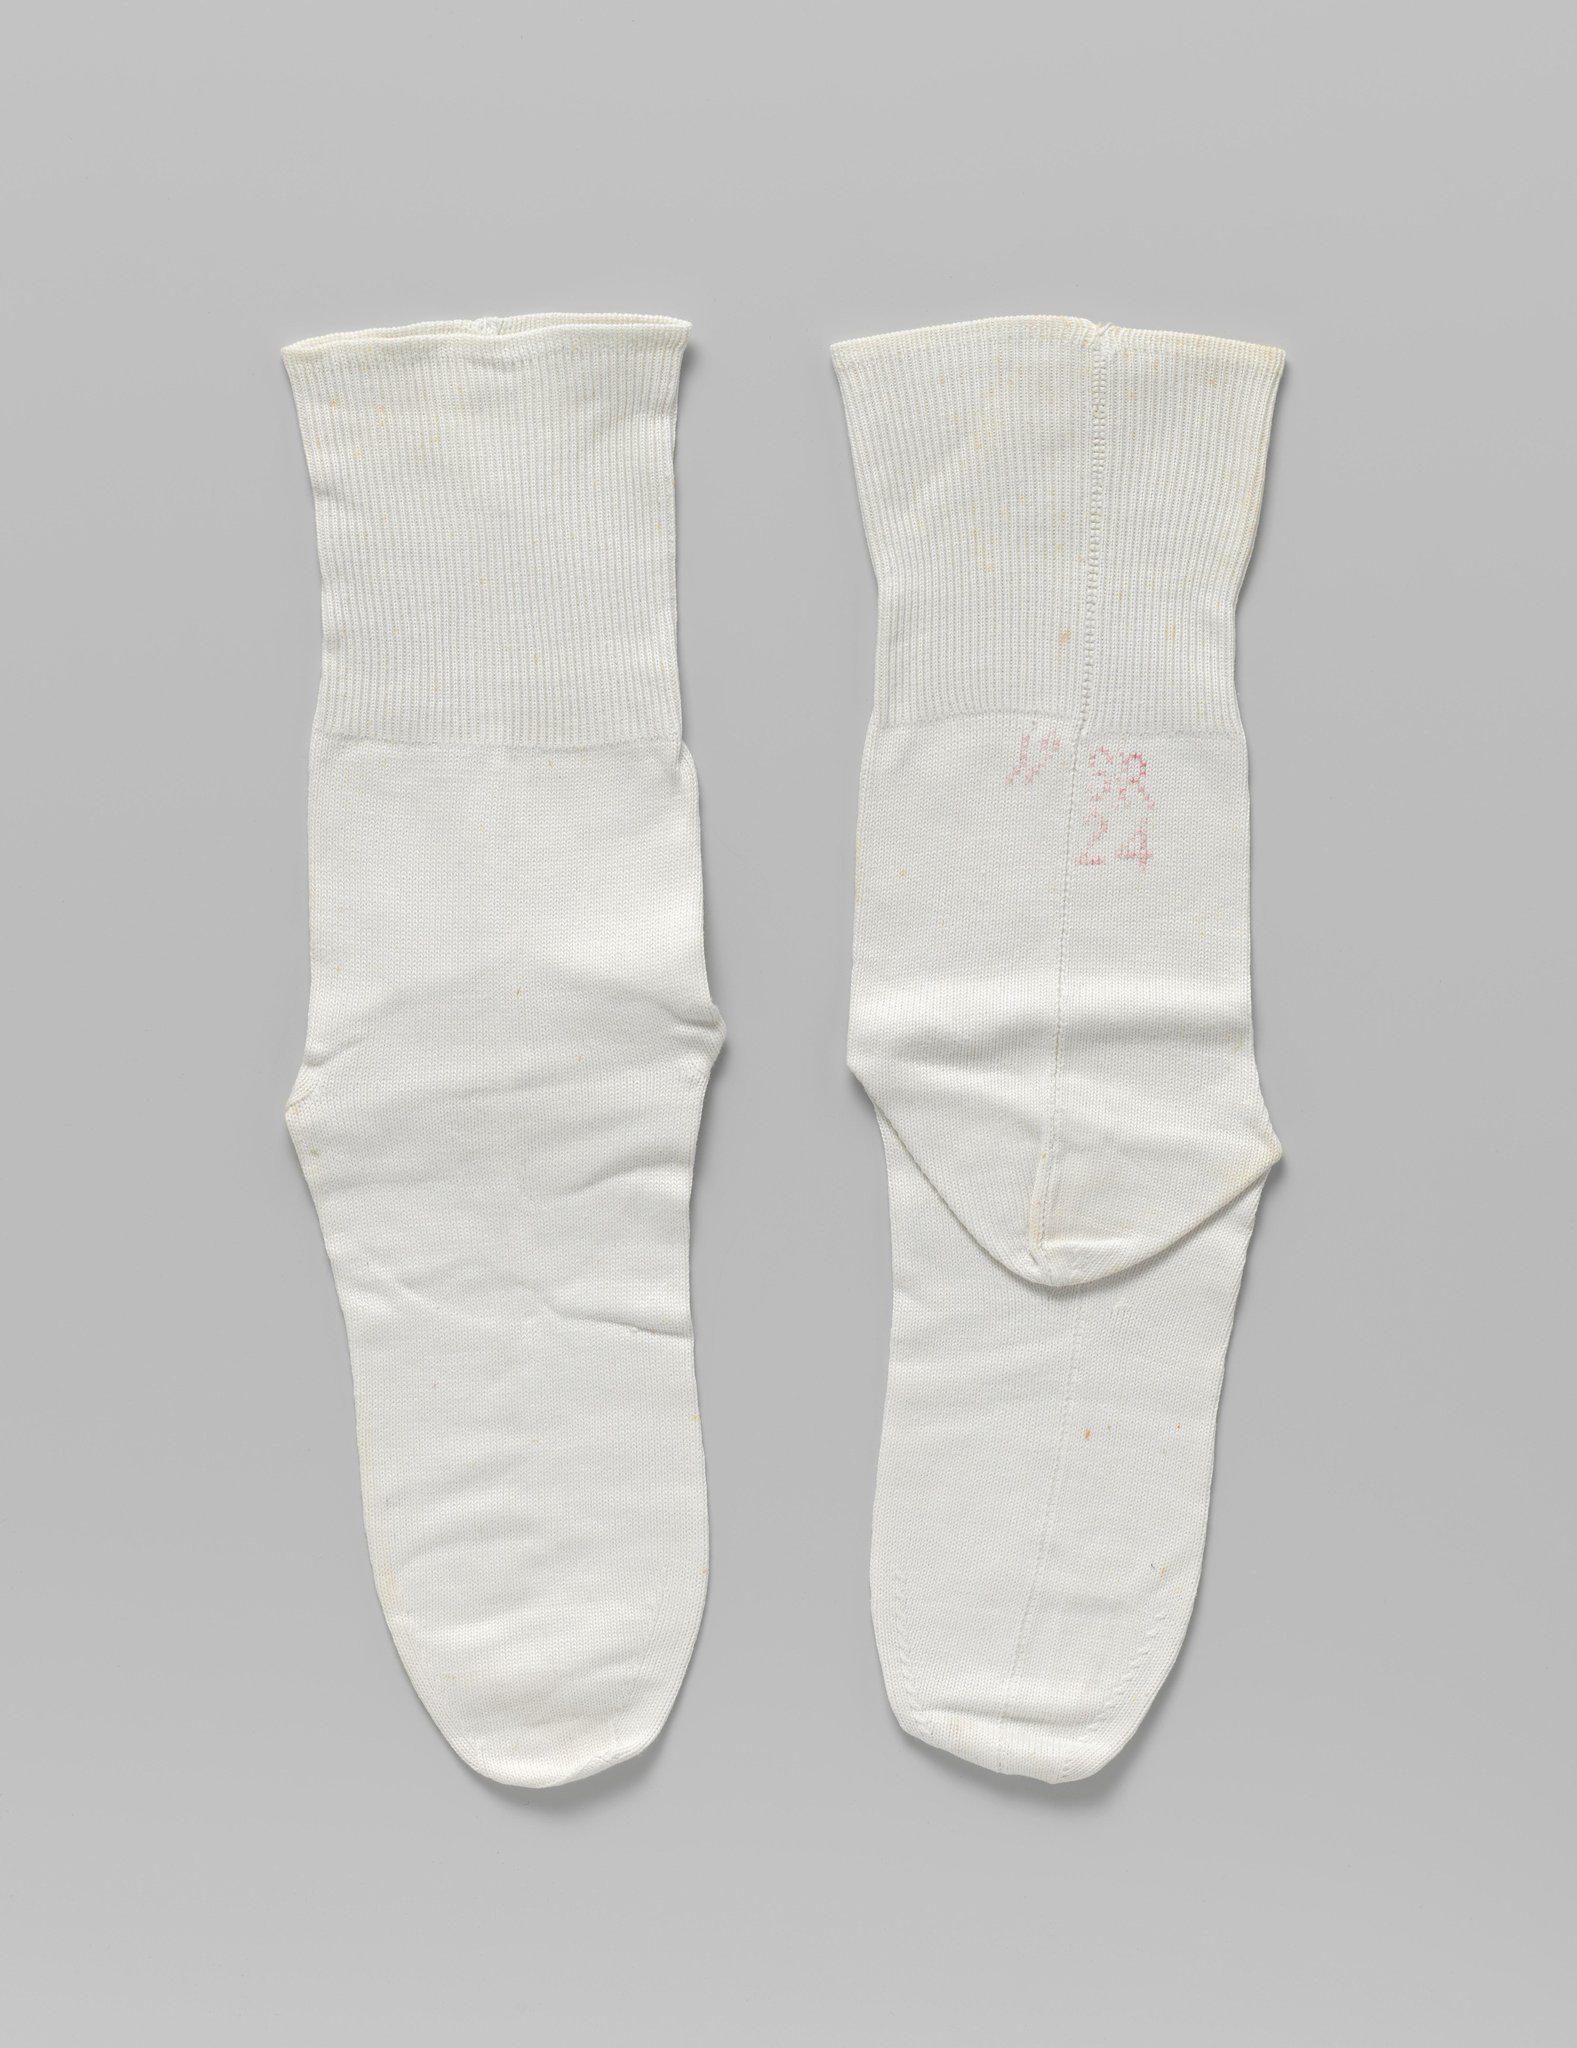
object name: menswear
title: Sok of kous van wit katoenen breiwerk; in rode kruissteek gemerkt: 19/SR/24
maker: Anonymous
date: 1900-1919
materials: cotton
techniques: cross stitching, knitting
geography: netherlands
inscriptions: initials: ‘19 SR / 24’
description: Sok of kous van wit katoenen breiwerk; in rode kruissteek gemerkt: 19/SR/24.